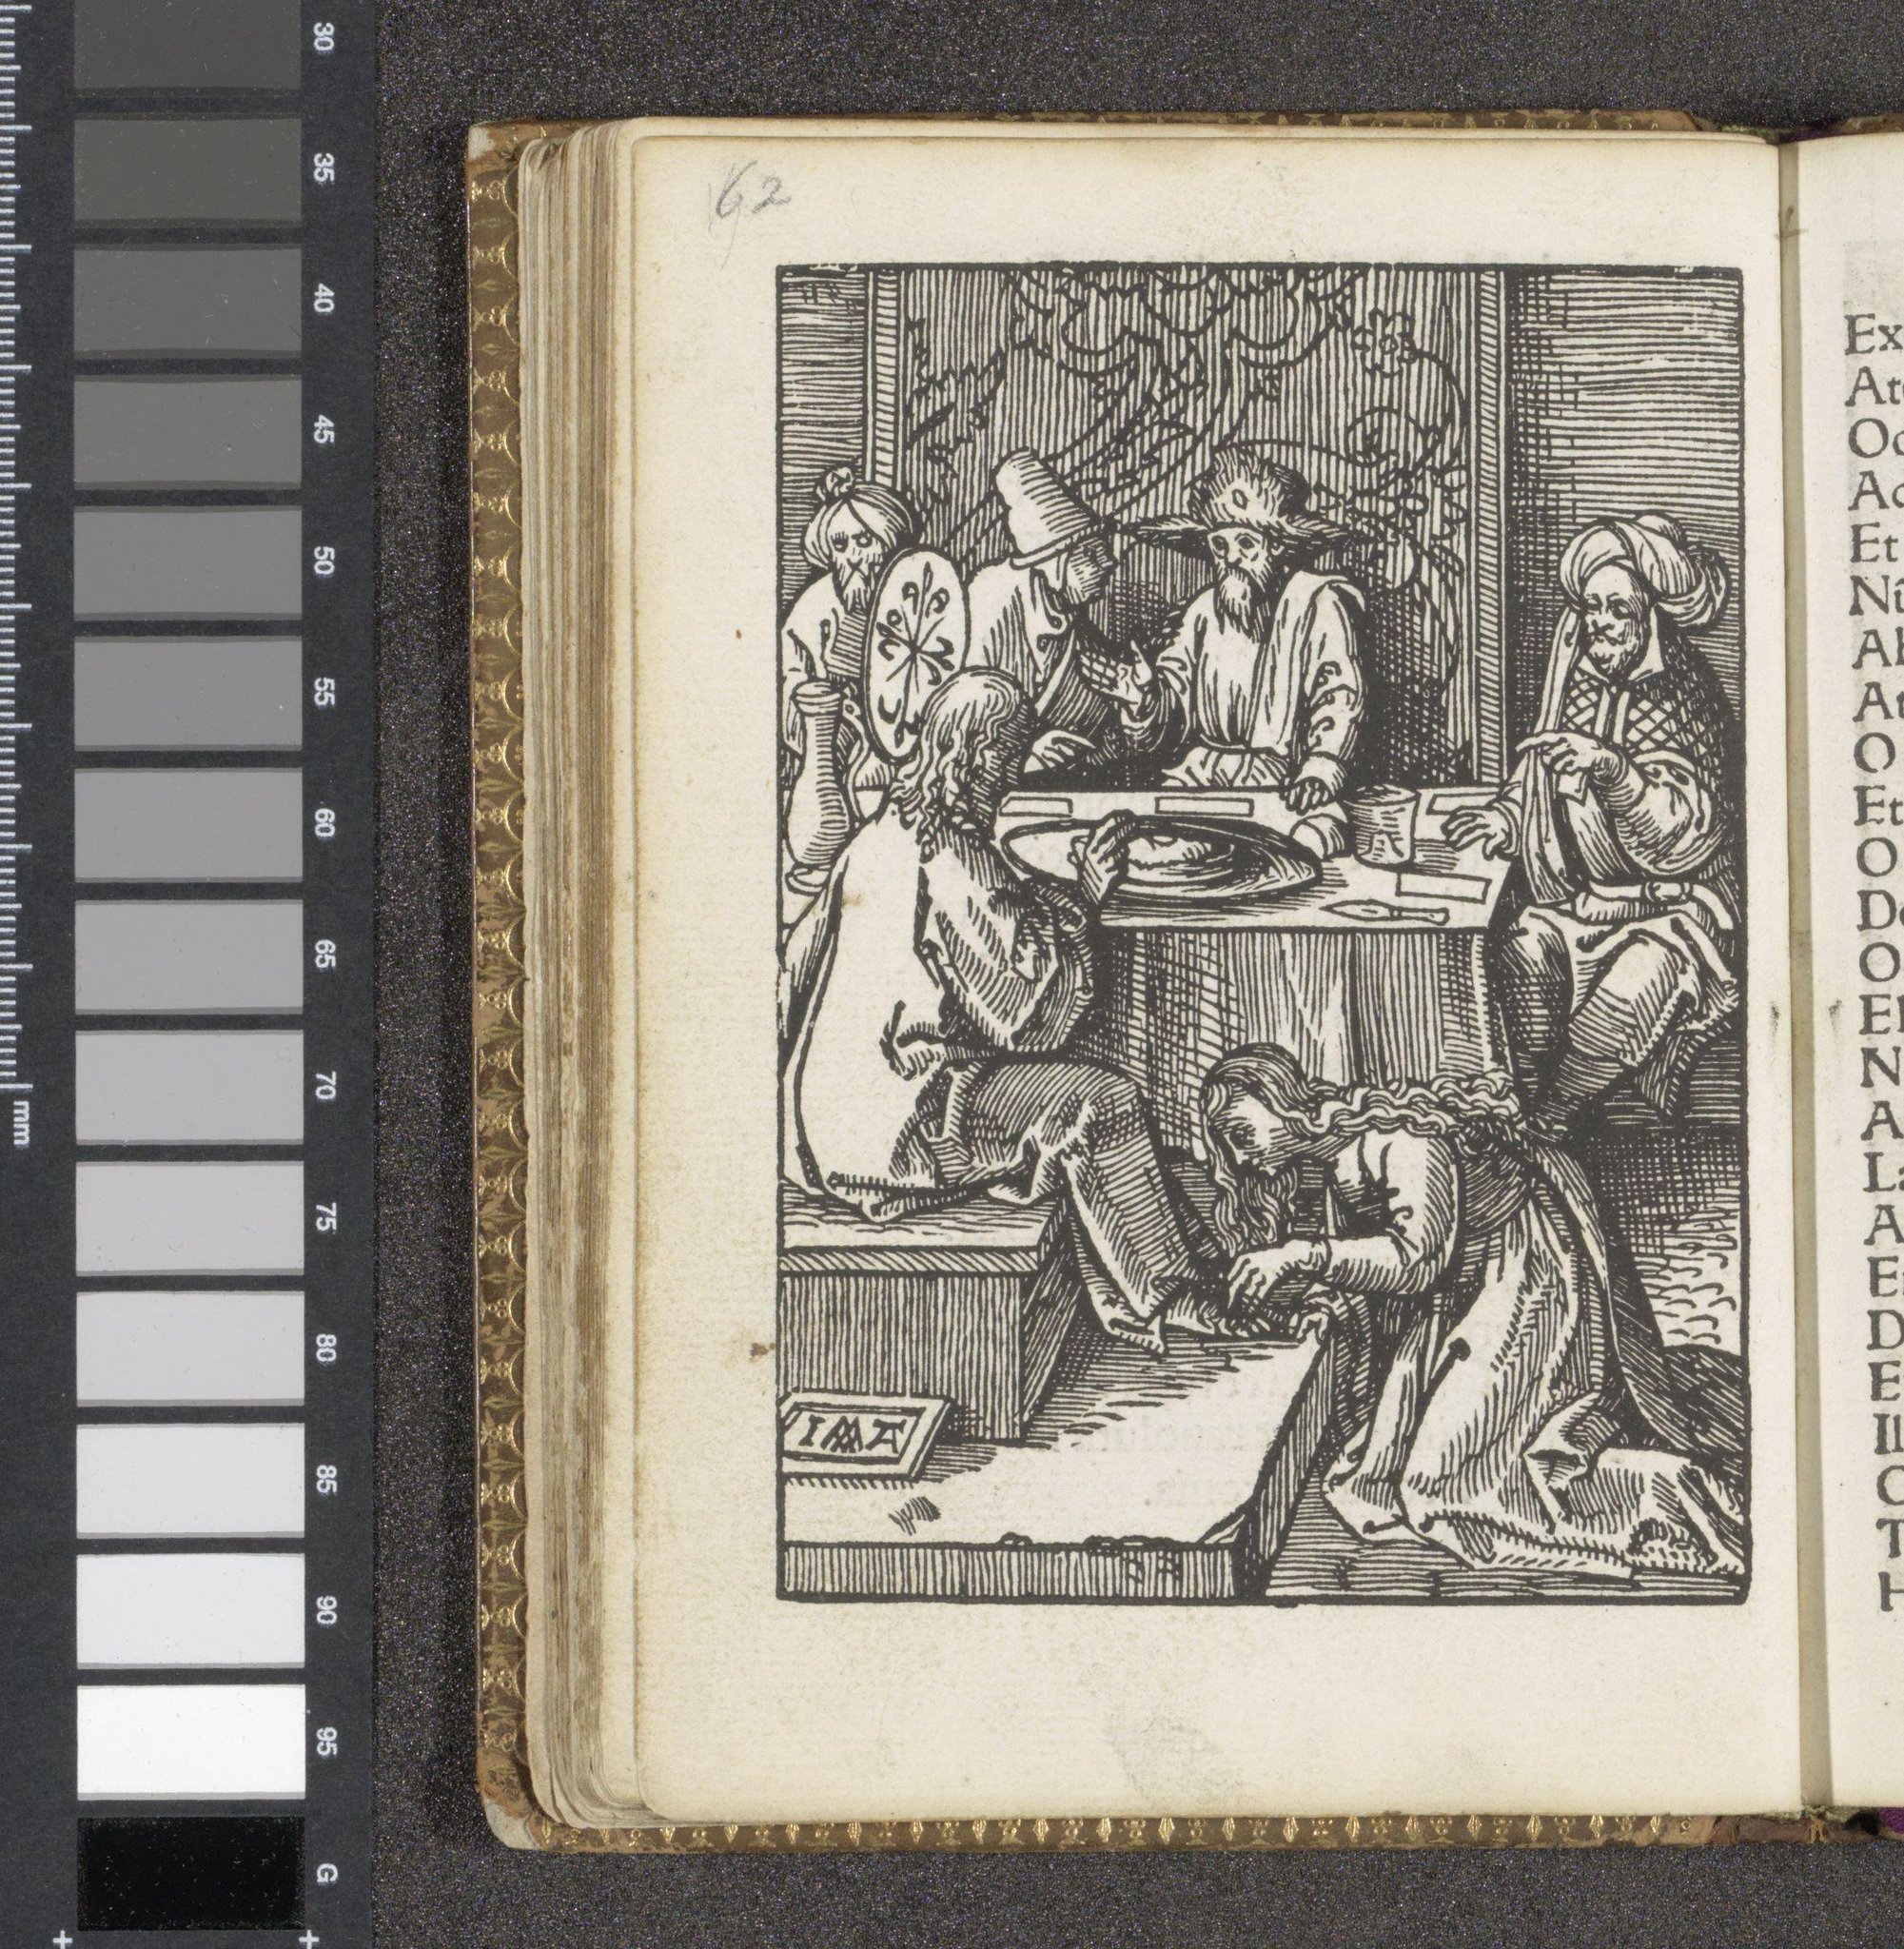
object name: print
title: De kleine Passie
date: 1523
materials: paper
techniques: woodcut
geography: amsterdam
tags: meal at the house of simon the pharisee (luke 7:36-50), a woman washes christ's feet with her tears, and wipes them with her hair, christ's feet are anointed by mary (magdalene), meal in bethany (at the house of simon the leper) (matthew 26:6-13; mark 14:3-9; john 12:1-11)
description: Christus zit aan tafel te eten in het huis van Simon de Farizeeër. Maria Magdalena knielt op de grond zalft zijn voeten en droogt ze met haar haren. Prent maakt deel uit van een boek.